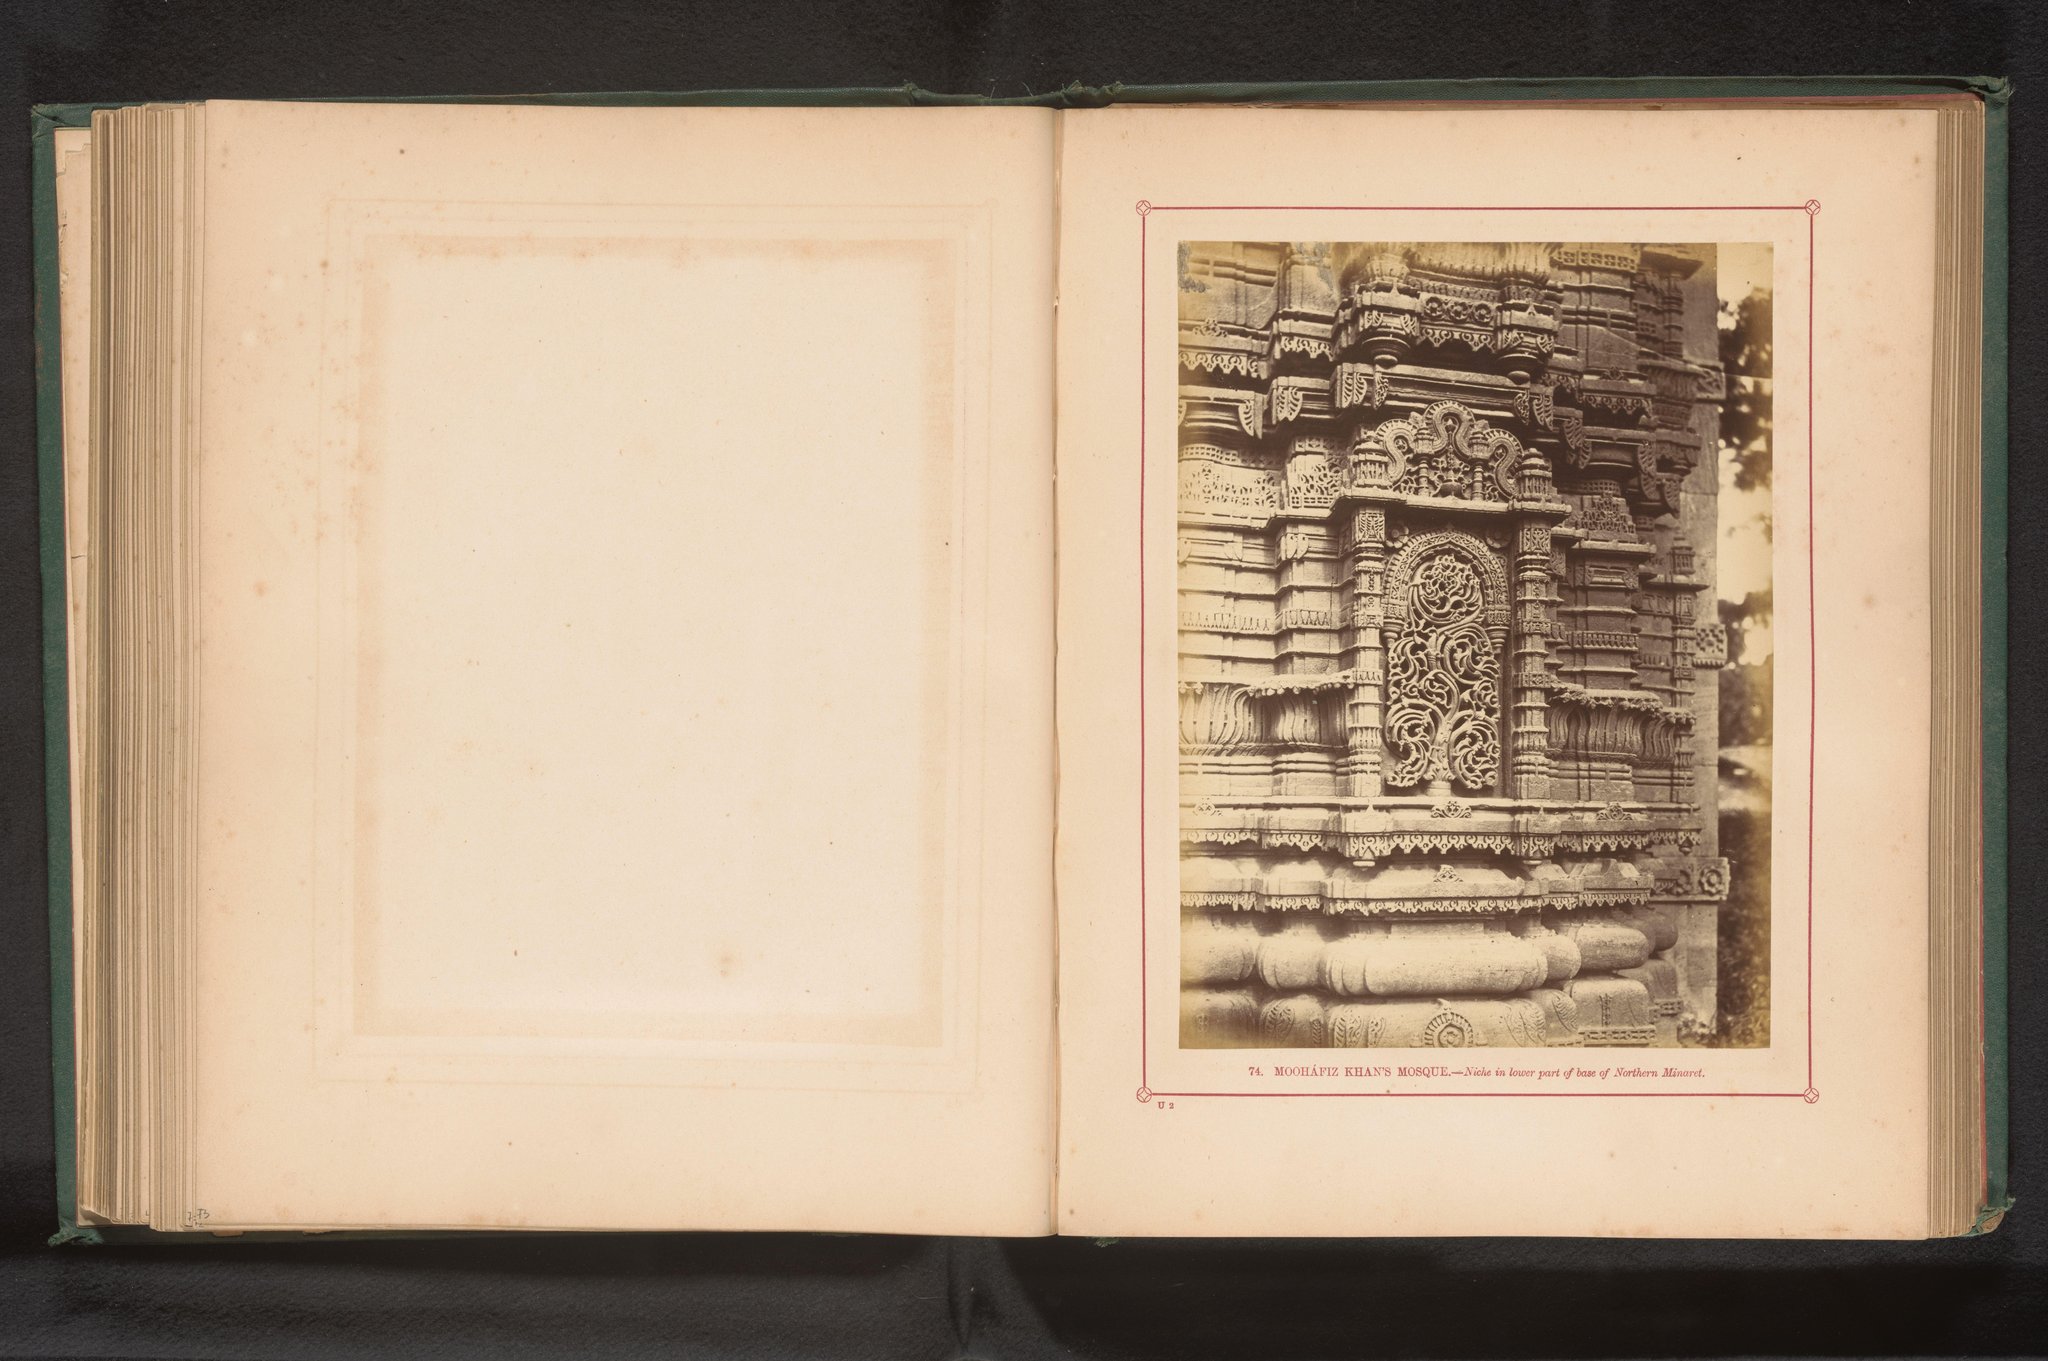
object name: page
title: Decoratie van een minaret van de Muhafiz Khan-moskee in Ahmedabad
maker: thomas biggs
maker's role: fotograaf, kapitein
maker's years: 1822-1905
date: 1856-1866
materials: photographic support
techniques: albumen print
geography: ahmedabad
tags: temple, shrine ~ islam, mohammedanism, base (~ column, pillar)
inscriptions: number: ‘74.’, inscription: ‘U2’